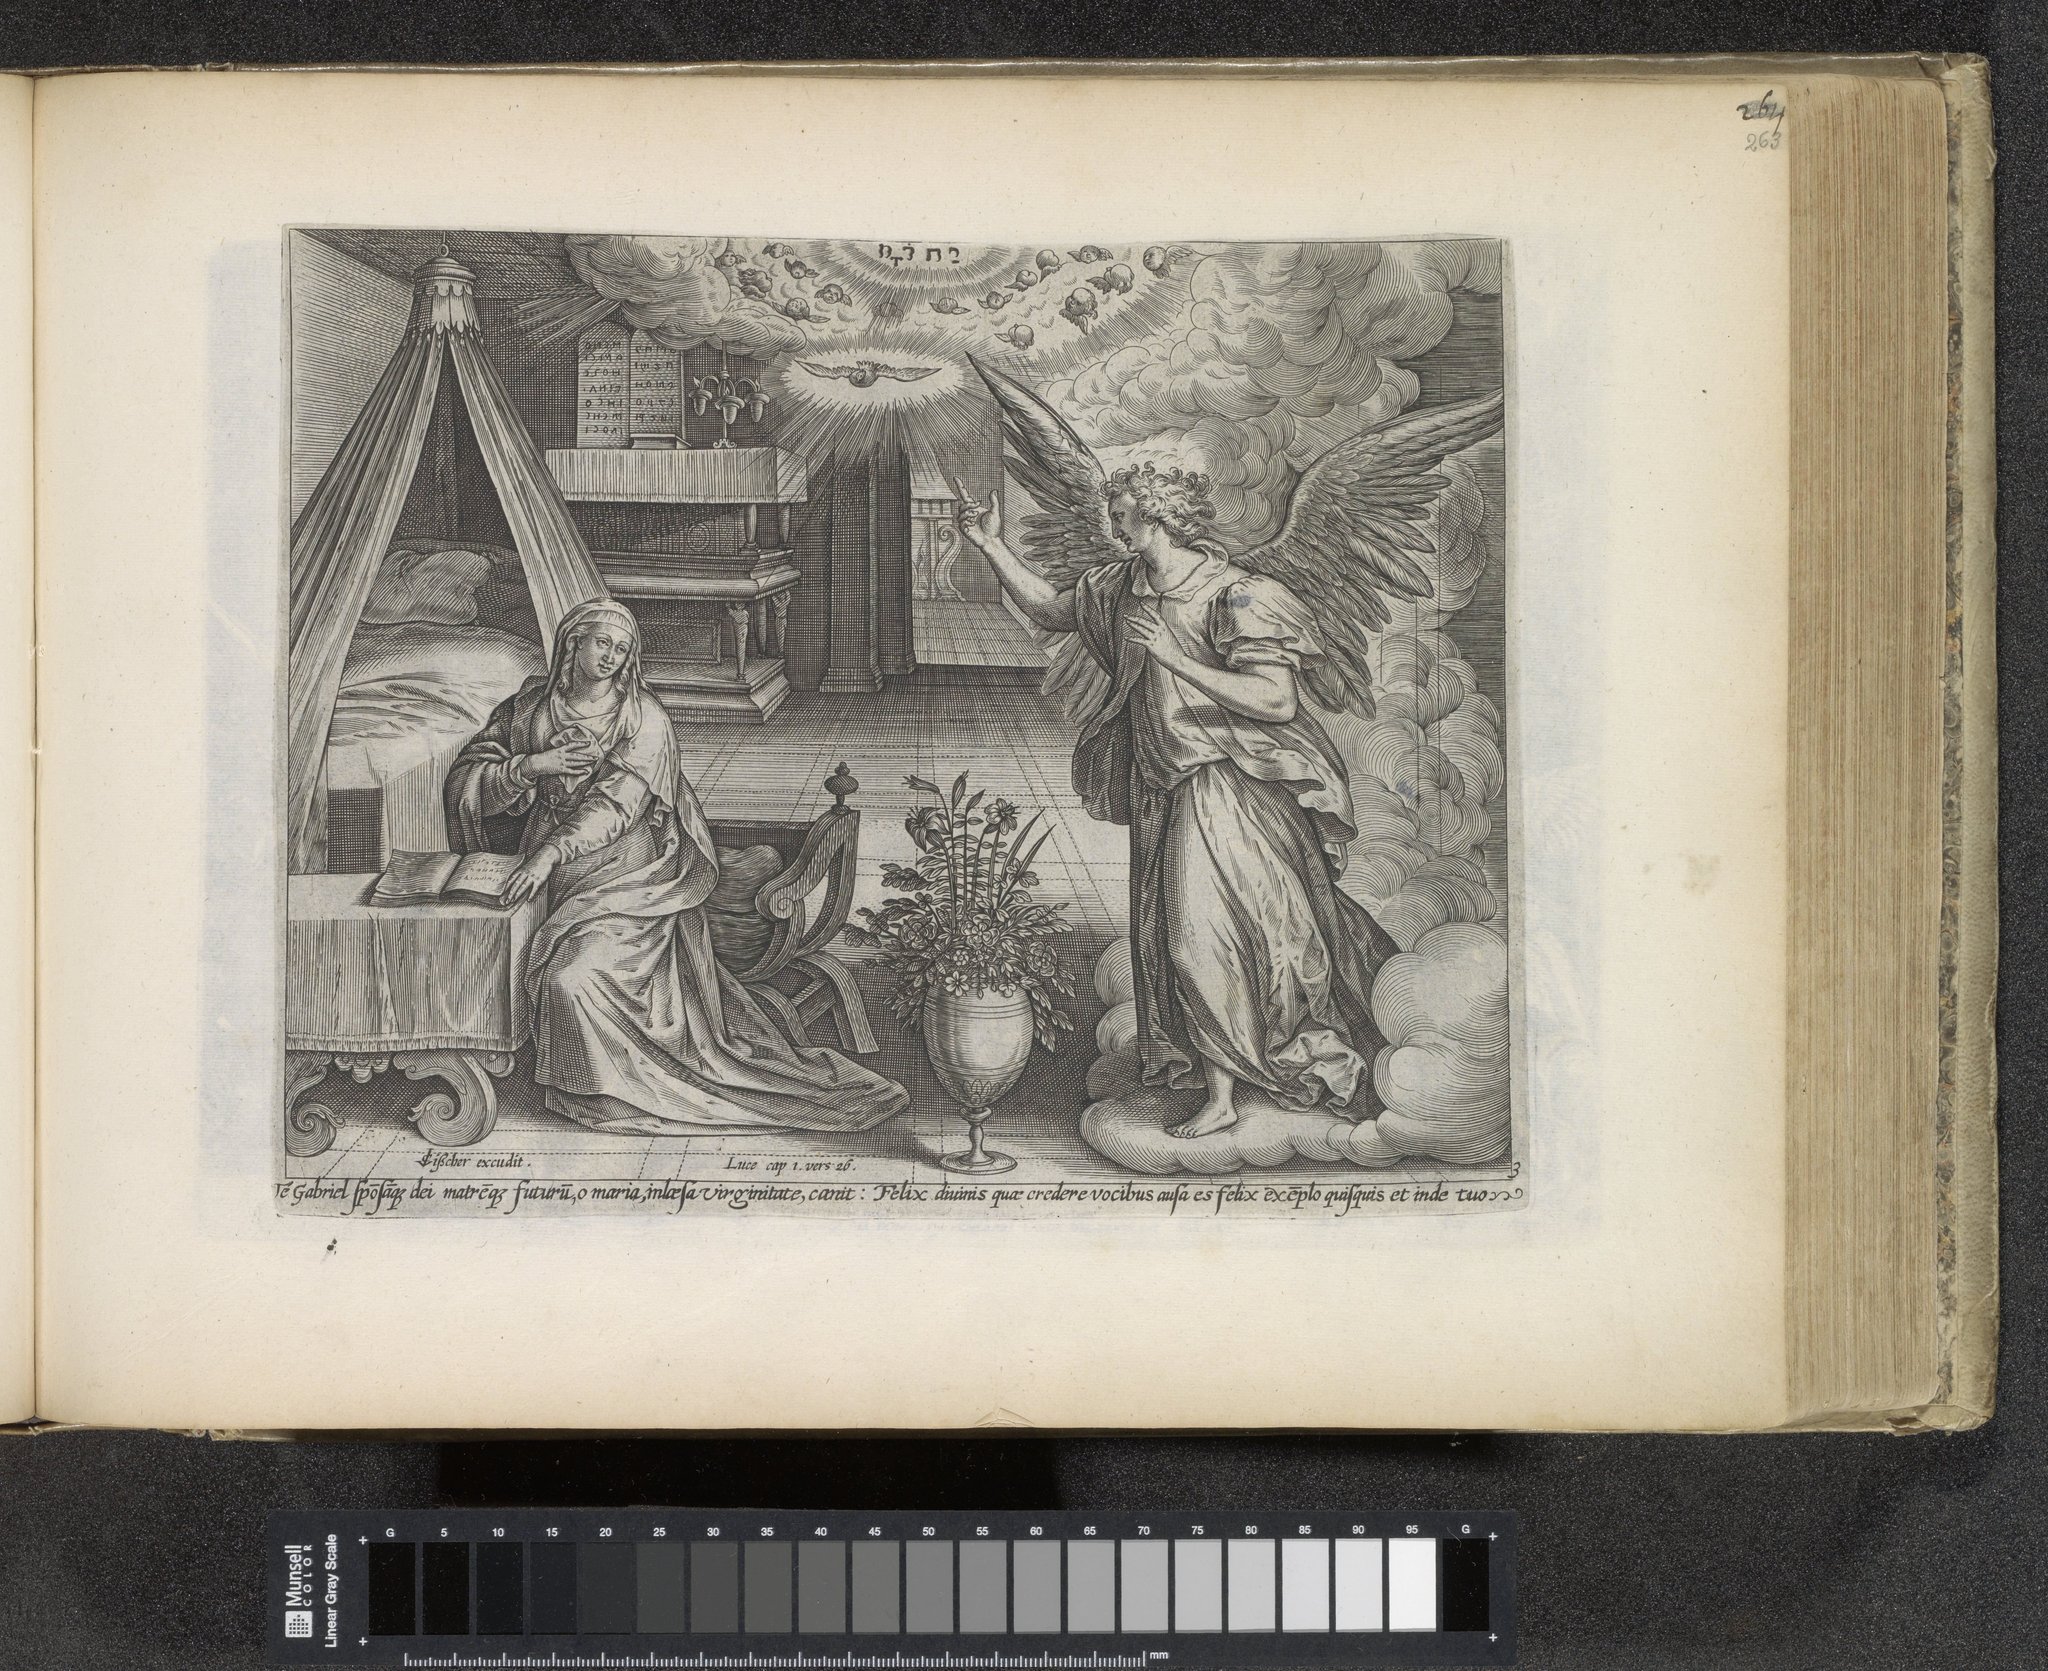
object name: print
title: Theatrum Biblicum Hoc Est Historiae Sacrae Veteris et Novi Testamenti Tabulis Aeneis Expressae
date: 1643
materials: paper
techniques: engraving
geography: amsterdam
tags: the annunciation: mary sitting - aa - mary to the left, the angel to the right, tetragram (in roman or hebrew script) ~ symbol of god the father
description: De engel Gabriël kondigt aan Maria aan dat ze zwanger zal worden. Maria zit bij een tafel, waarop een opengeslagen boek ligt. Links een bed. De Heilige Geest daalt als een duif neer. Daarboven het tetragram als symbool van God de Vader en cherubijnen. Onder de voorstelling een verwijzing in het Latijn naar de Bijbeltekst in Luc. 1:26. Deze prent maakt deel uit van een album.